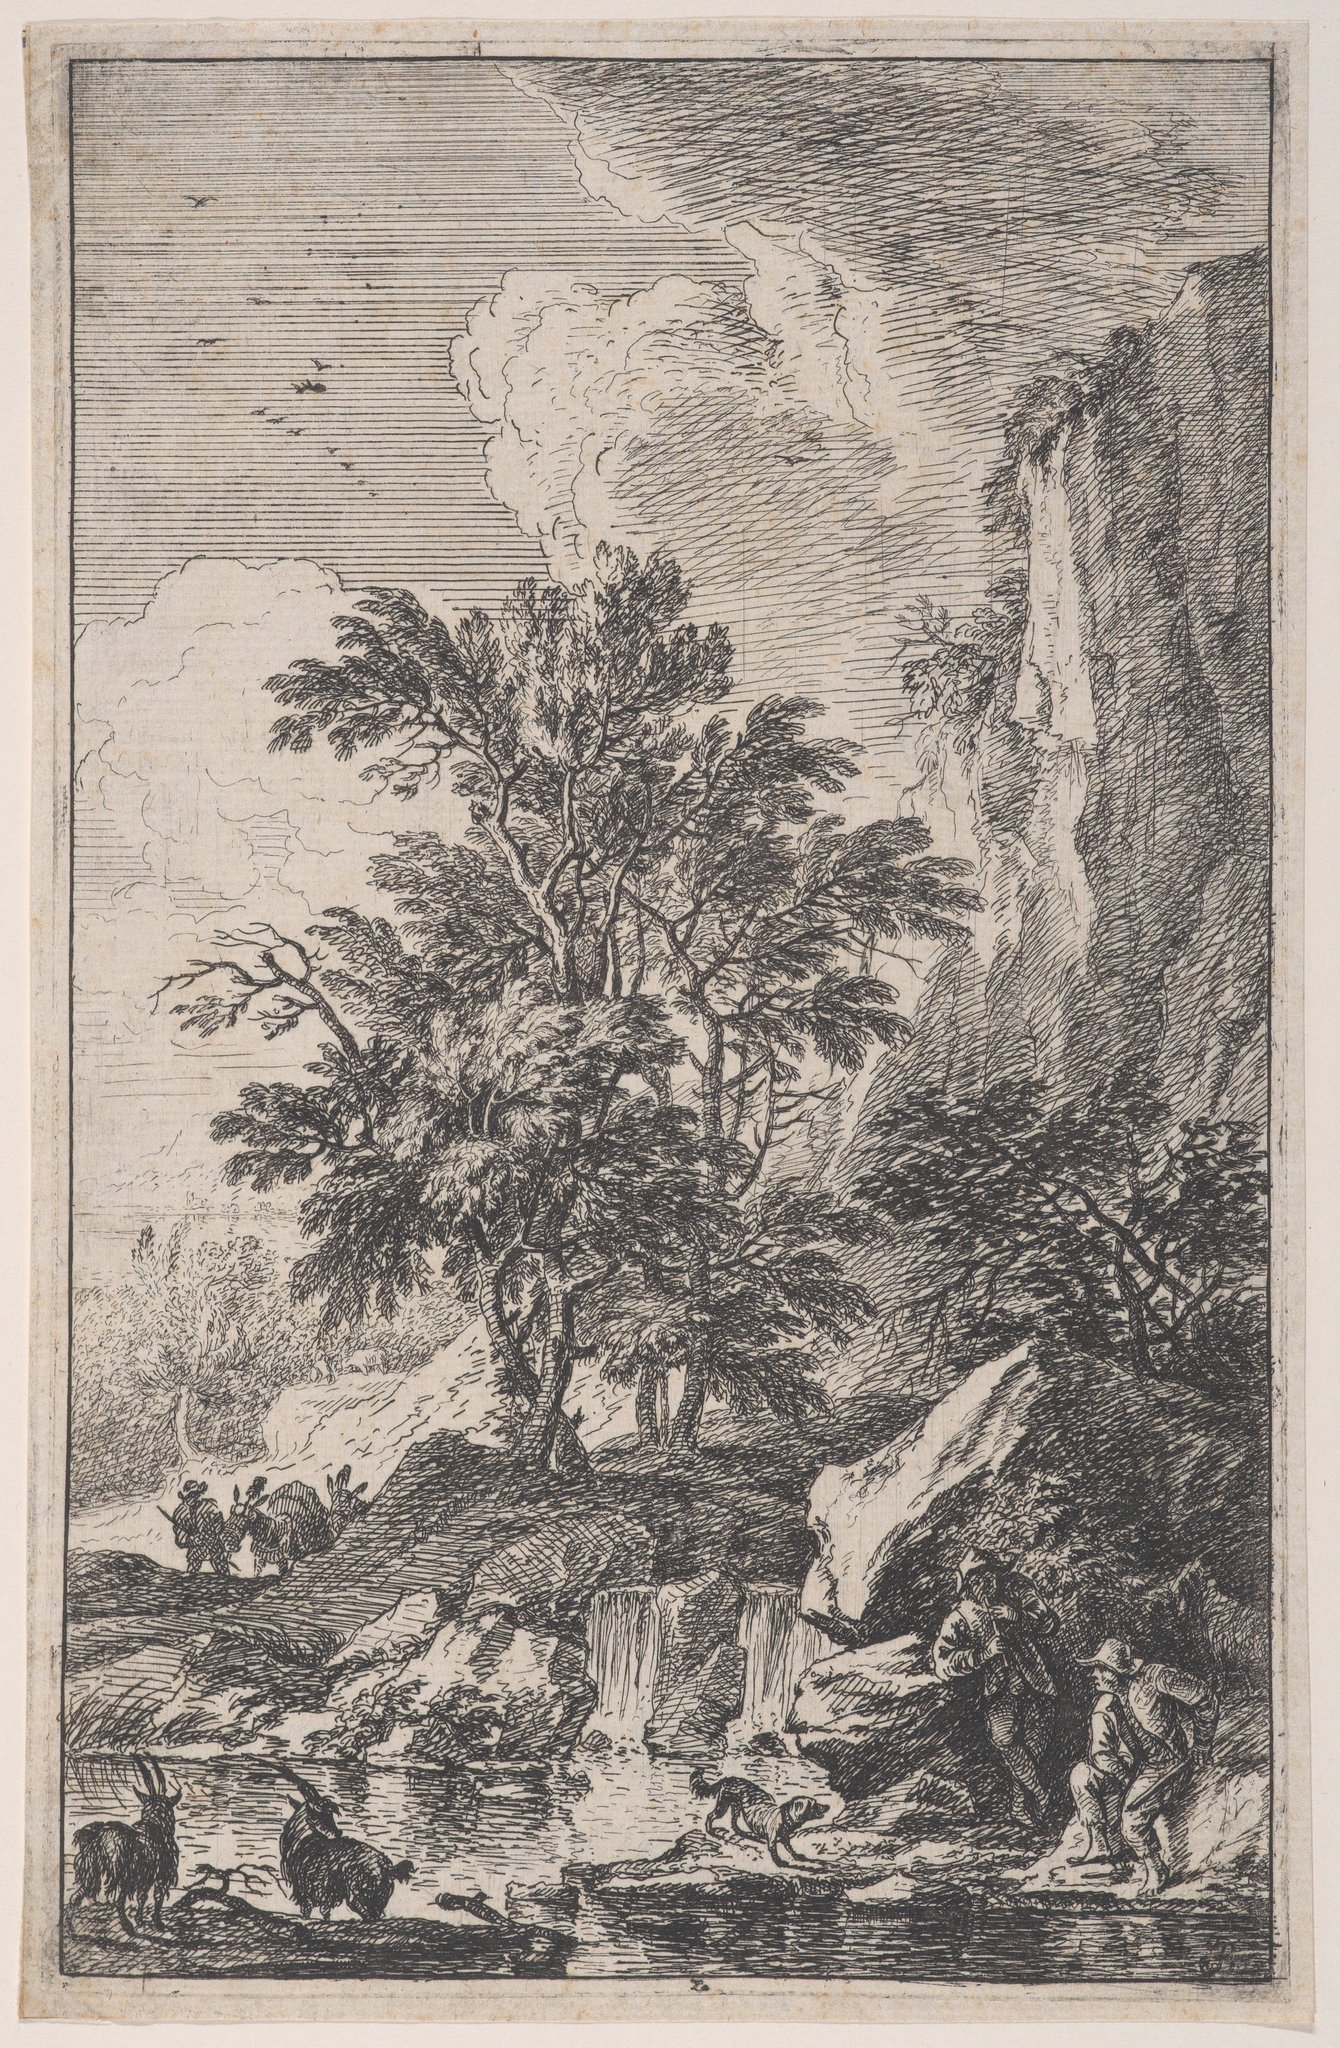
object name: print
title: Plate 3: two goats on a lakeshore, two male figures and a dog at right, another peasant approaching with a mule at left in the background, from 'Landscapes in the manner of Salvator Rosa' (Die Landschaften in Sal. Rosa's)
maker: franz joachim beich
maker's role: artist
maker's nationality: german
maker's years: 1665-1745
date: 1700-1725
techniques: etching